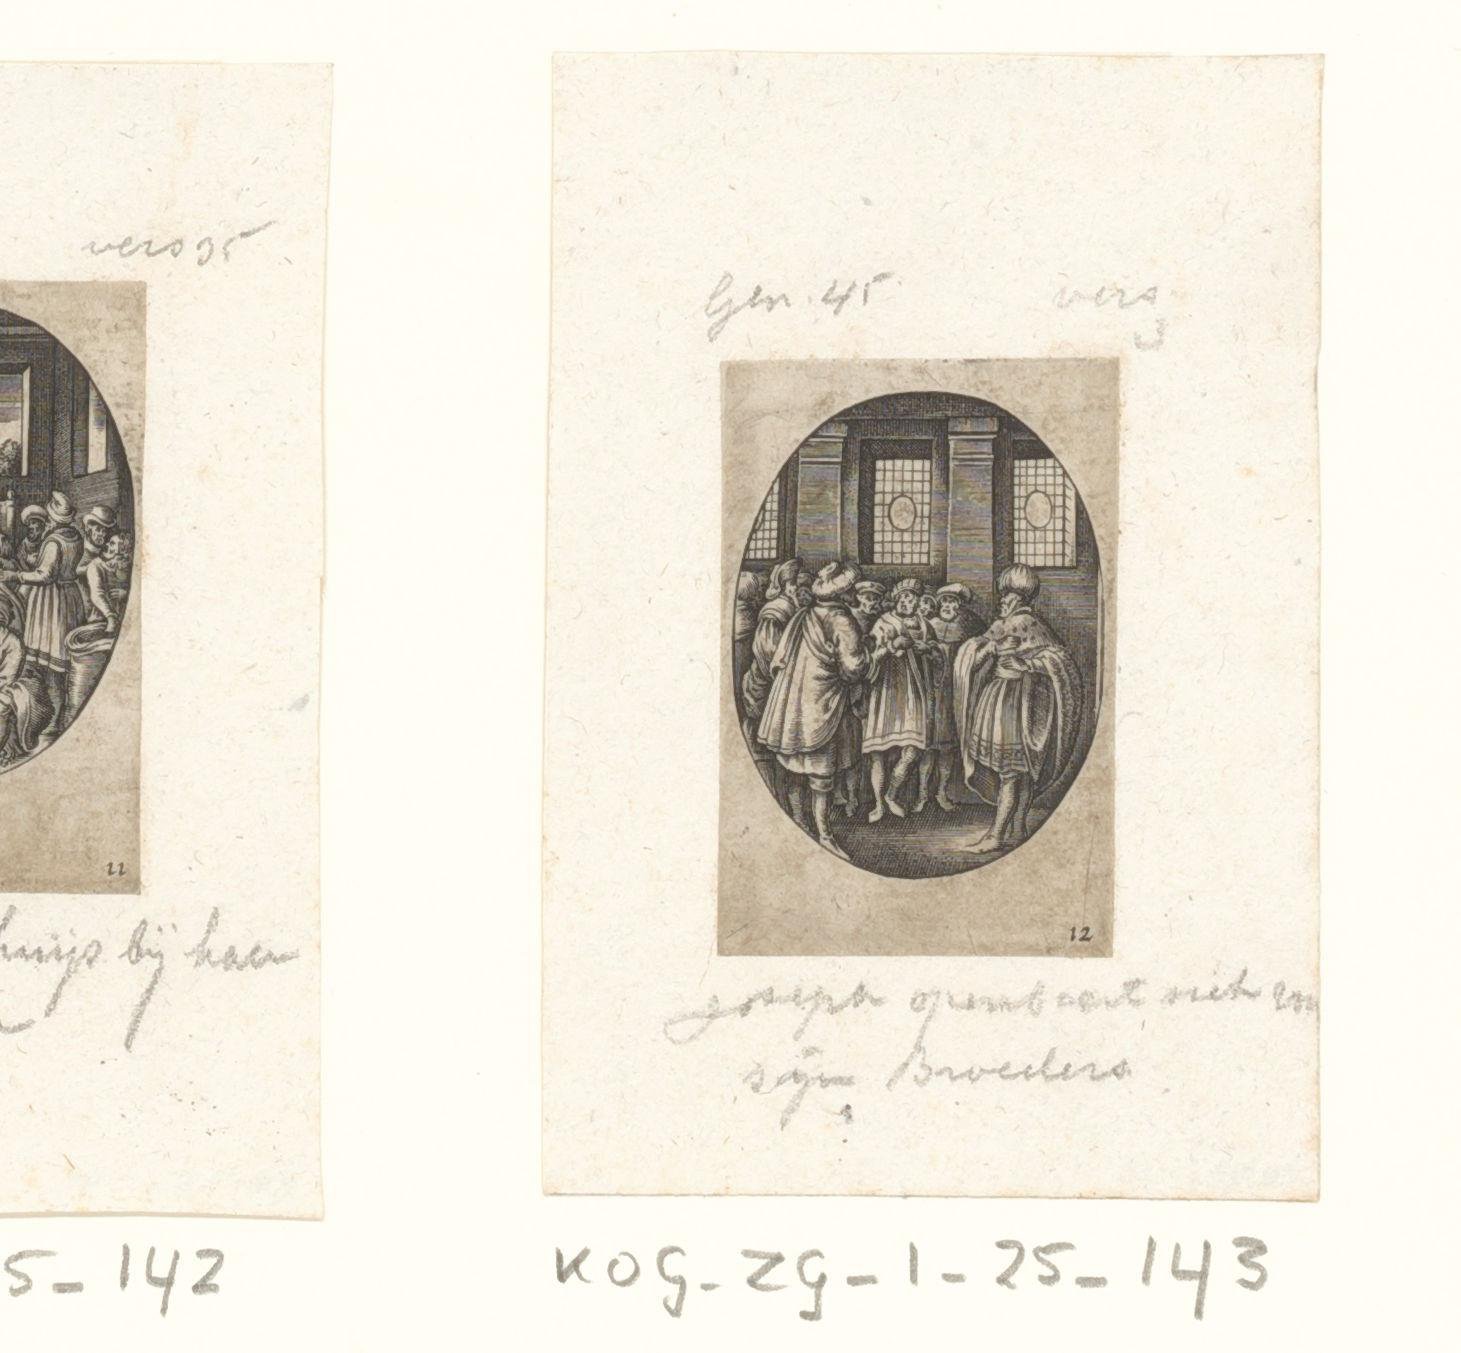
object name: print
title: Jozef maakt zich aan zijn broers bekend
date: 1605-1652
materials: paper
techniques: engraving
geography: amsterdam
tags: story of joseph (part i), joseph reveals his identity and in tears forgives his brothers' past misdeed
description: een interieur met Jozef die zich aan zijn broers bekend maakt (Gen. 45-3). Rechtsonder genummerd: 12. Onderwerpsrubrieken binnen de Atlas Zeden en Gewoonten: Zeden en Gewoonten in Engeren Zin, De Woning, Huisraad, Zilverwerk.